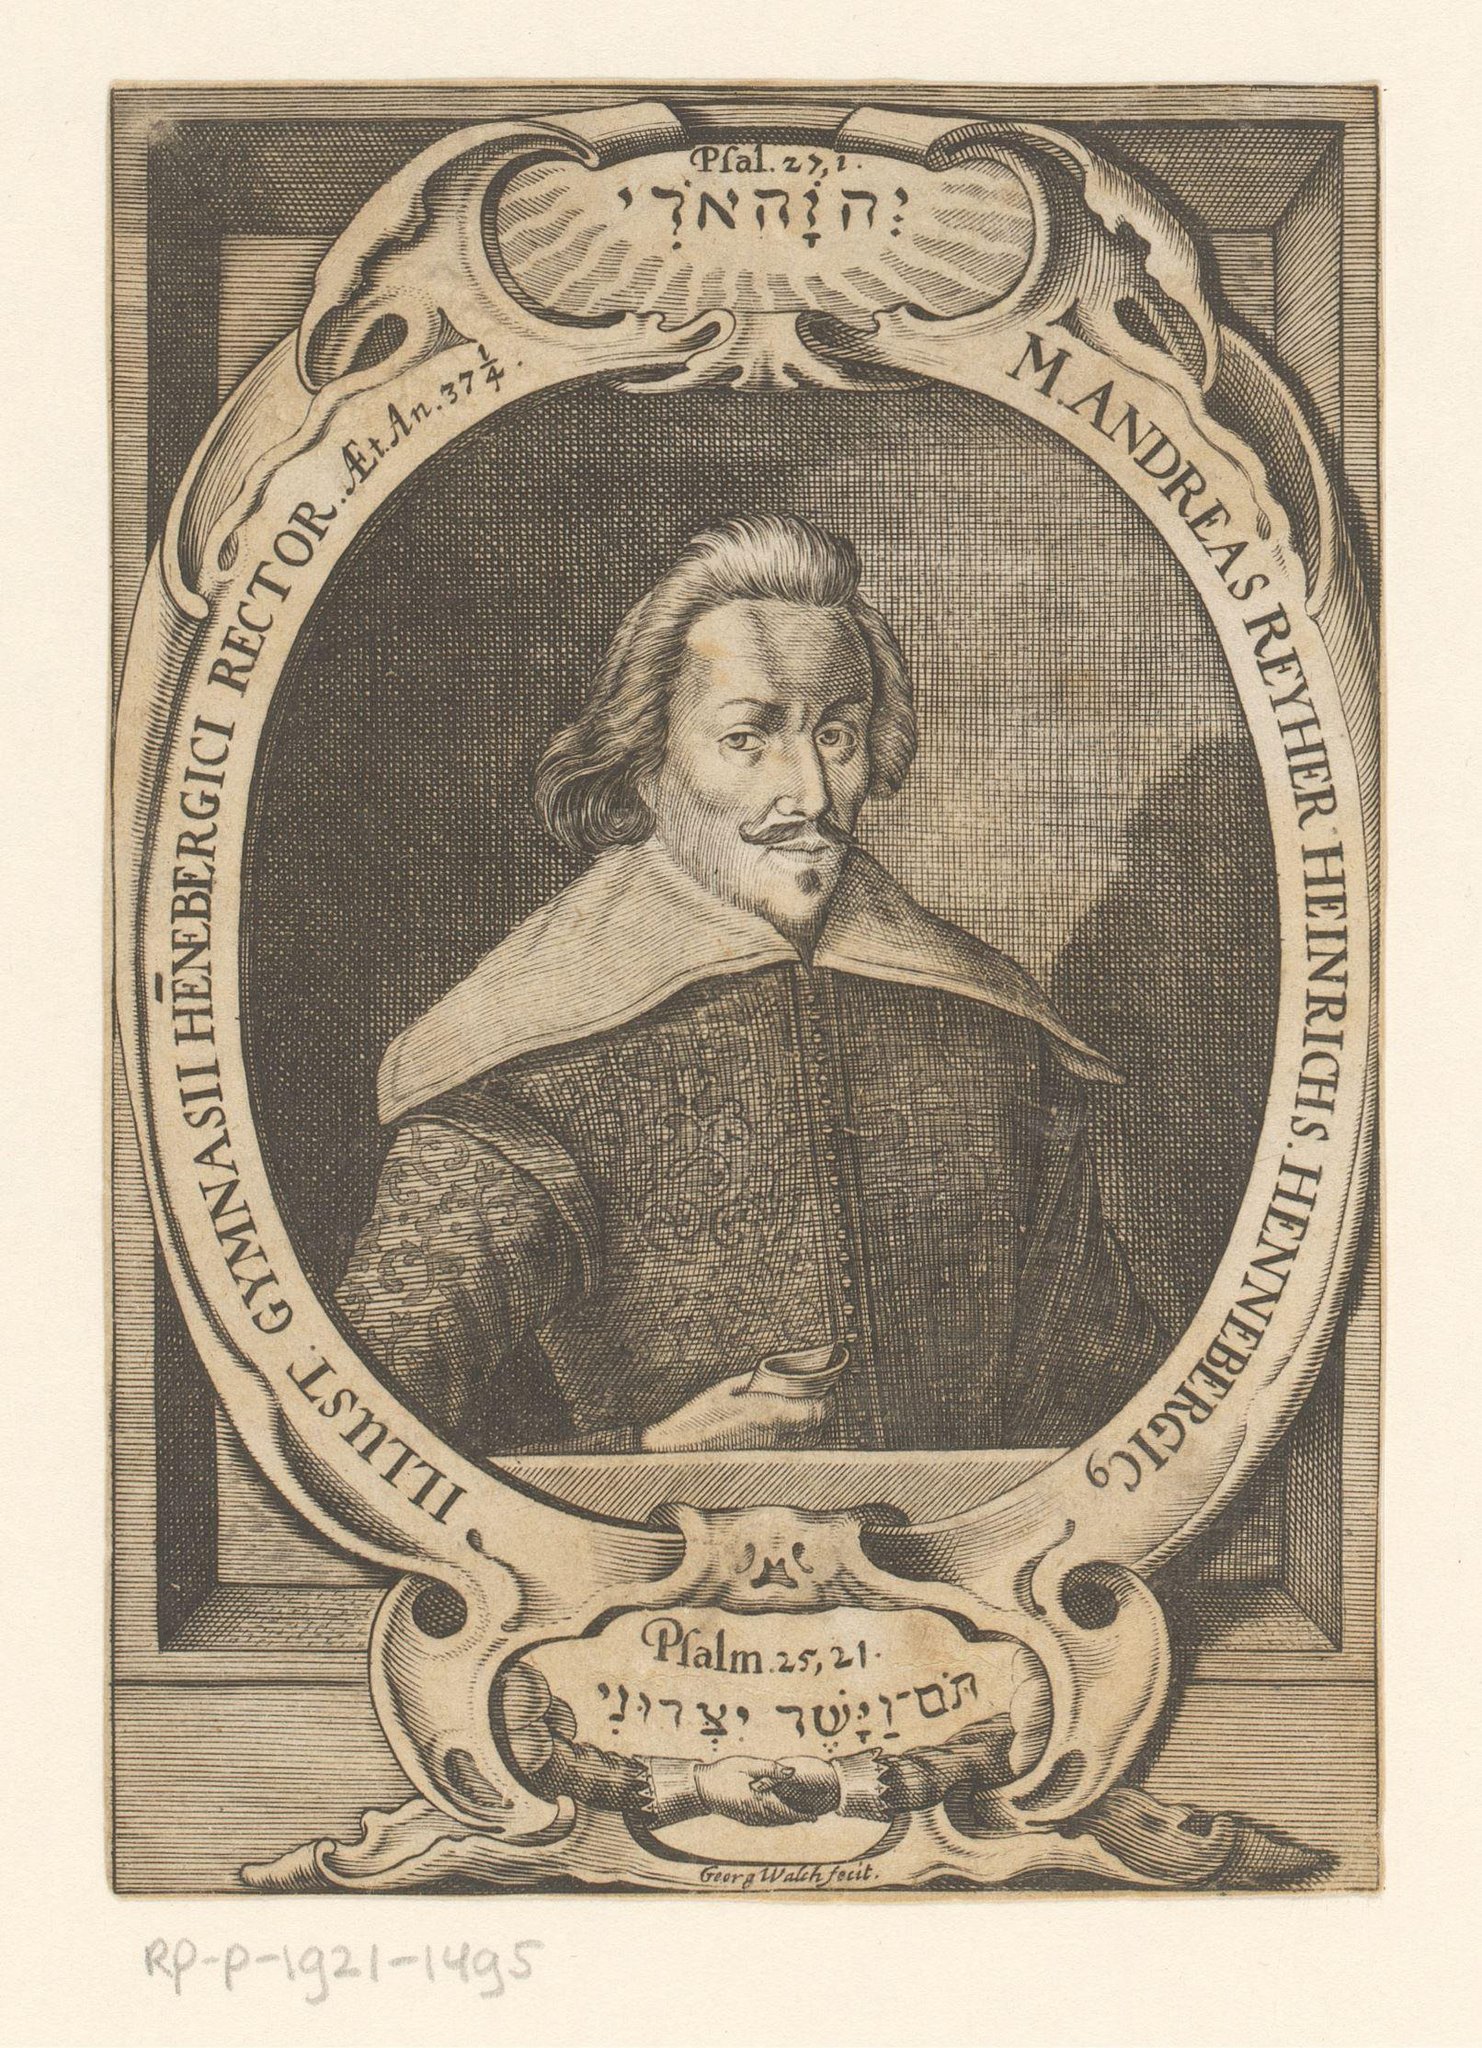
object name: print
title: M. Andreas Reyher Heinrichs (...)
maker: georg walch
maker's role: print maker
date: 1638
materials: paper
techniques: engraving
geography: nuremberg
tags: printer, historical persons, scholastic education, tuition (+ teacher, professor)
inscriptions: collector's mark: Lugt 2233